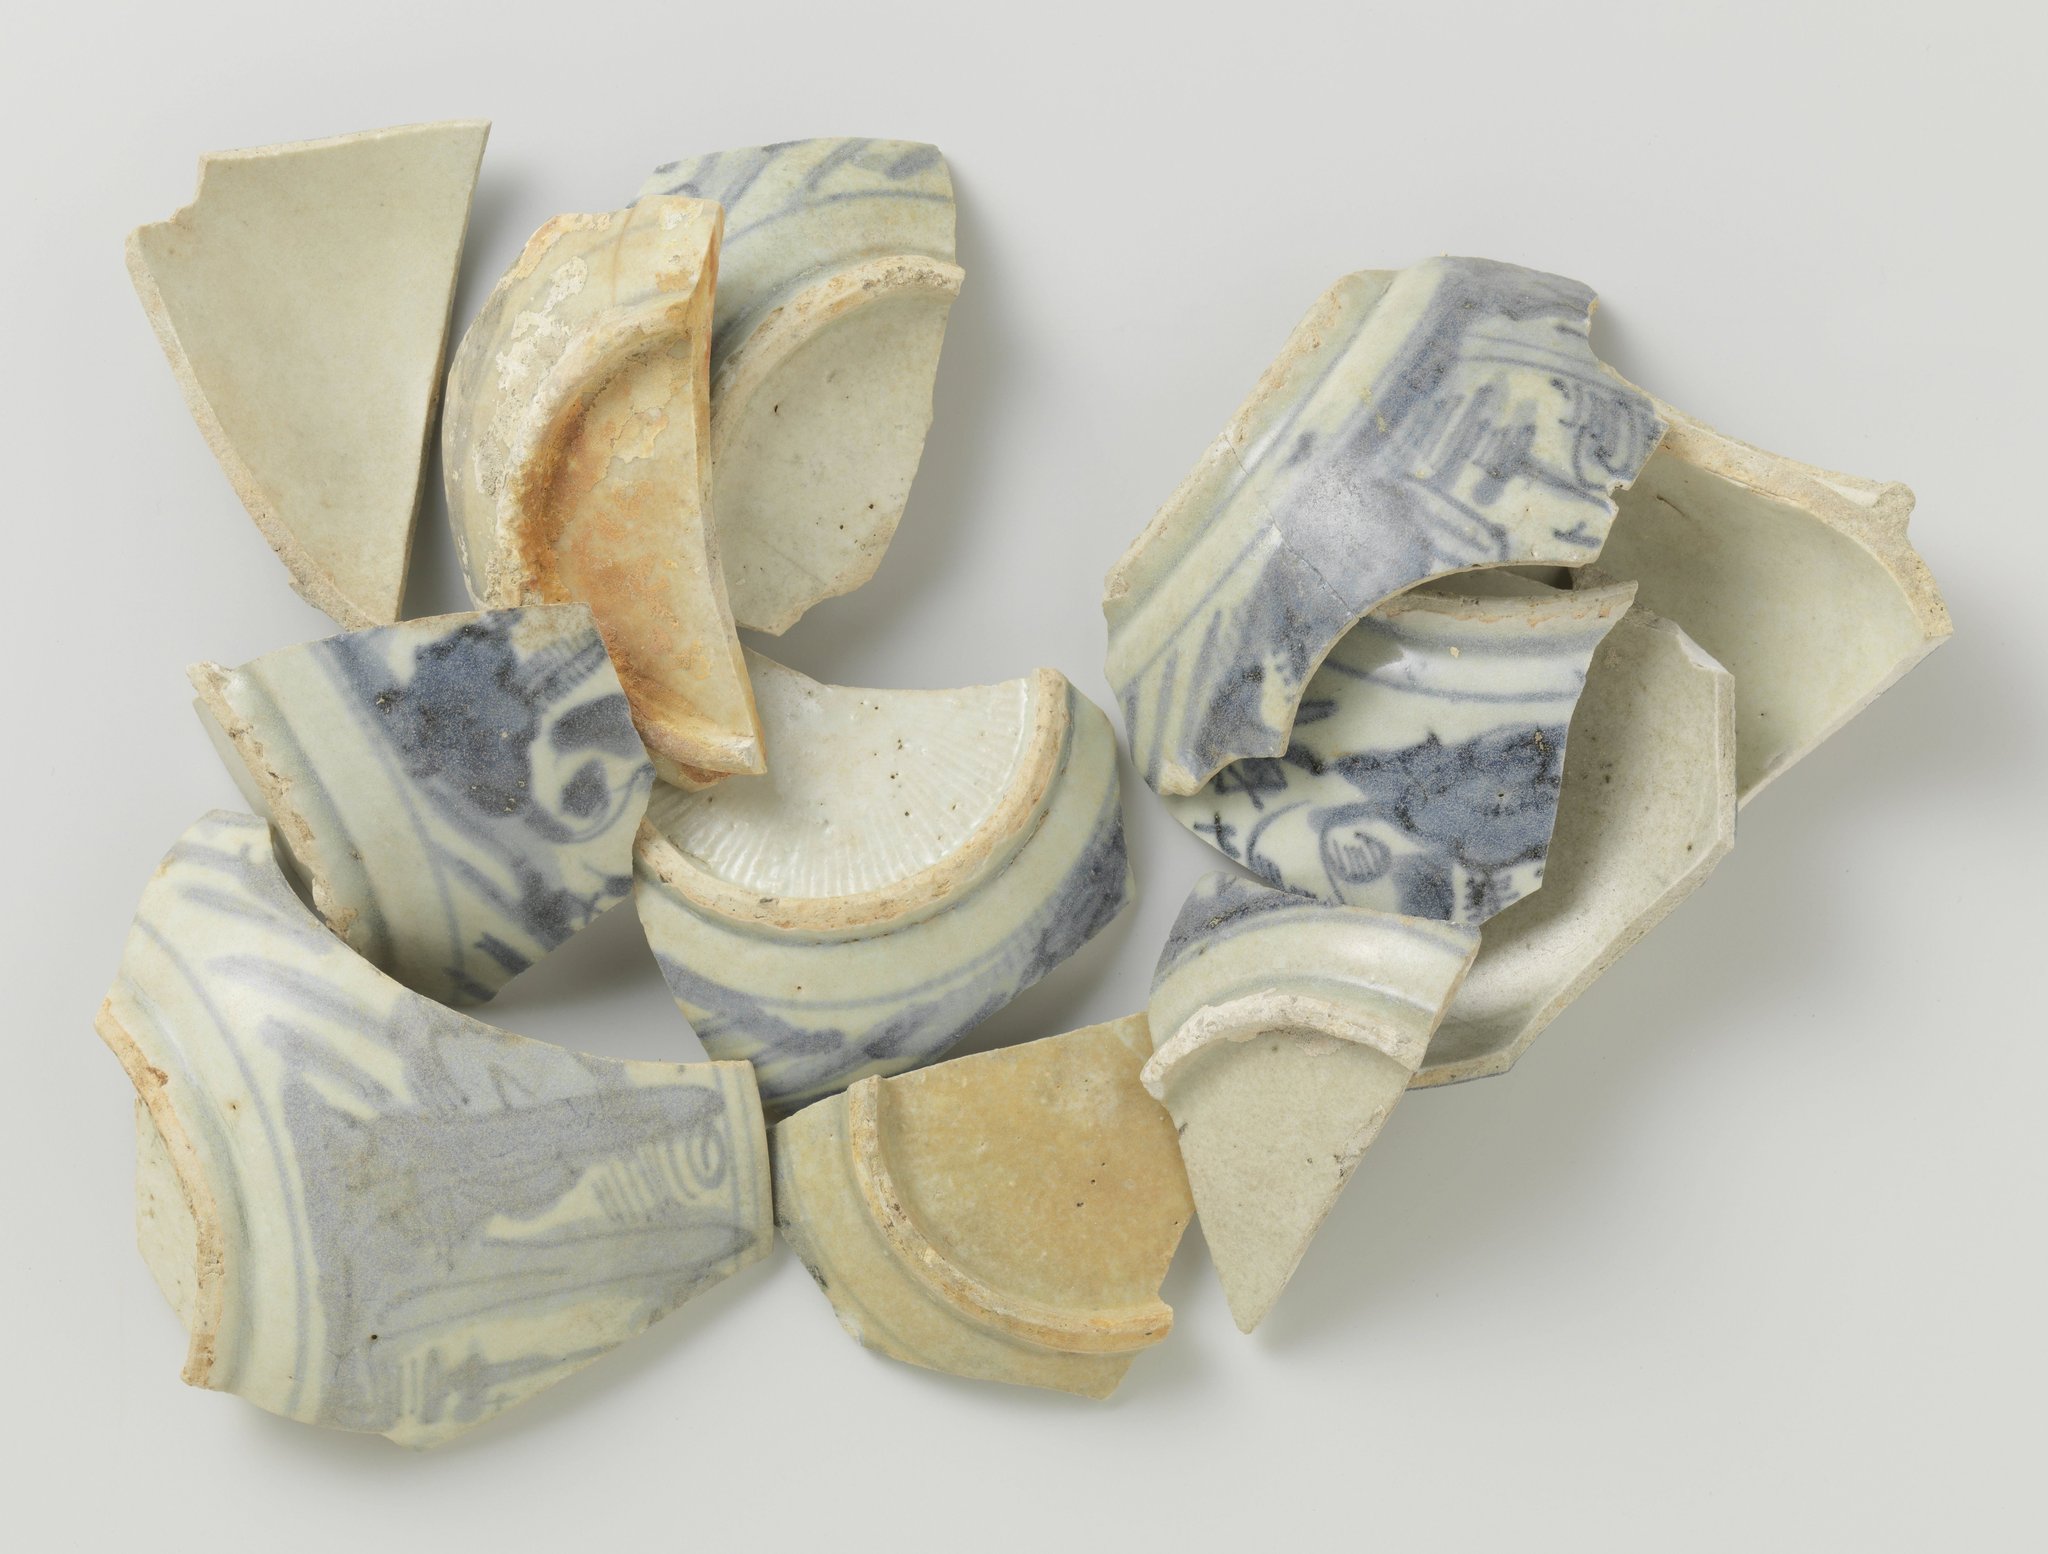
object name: lid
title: Scherven van bodems en deksels van porselein uit V.O.C.-schip de 'Witte Leeuw'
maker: Anonymous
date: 1613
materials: porcelain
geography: jingdezhen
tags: verenigde oostindische compagnie, sint-helena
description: Scherven van bodems en deksels van porselein uit V.O.C.-schip de 'Witte Leeuw'.